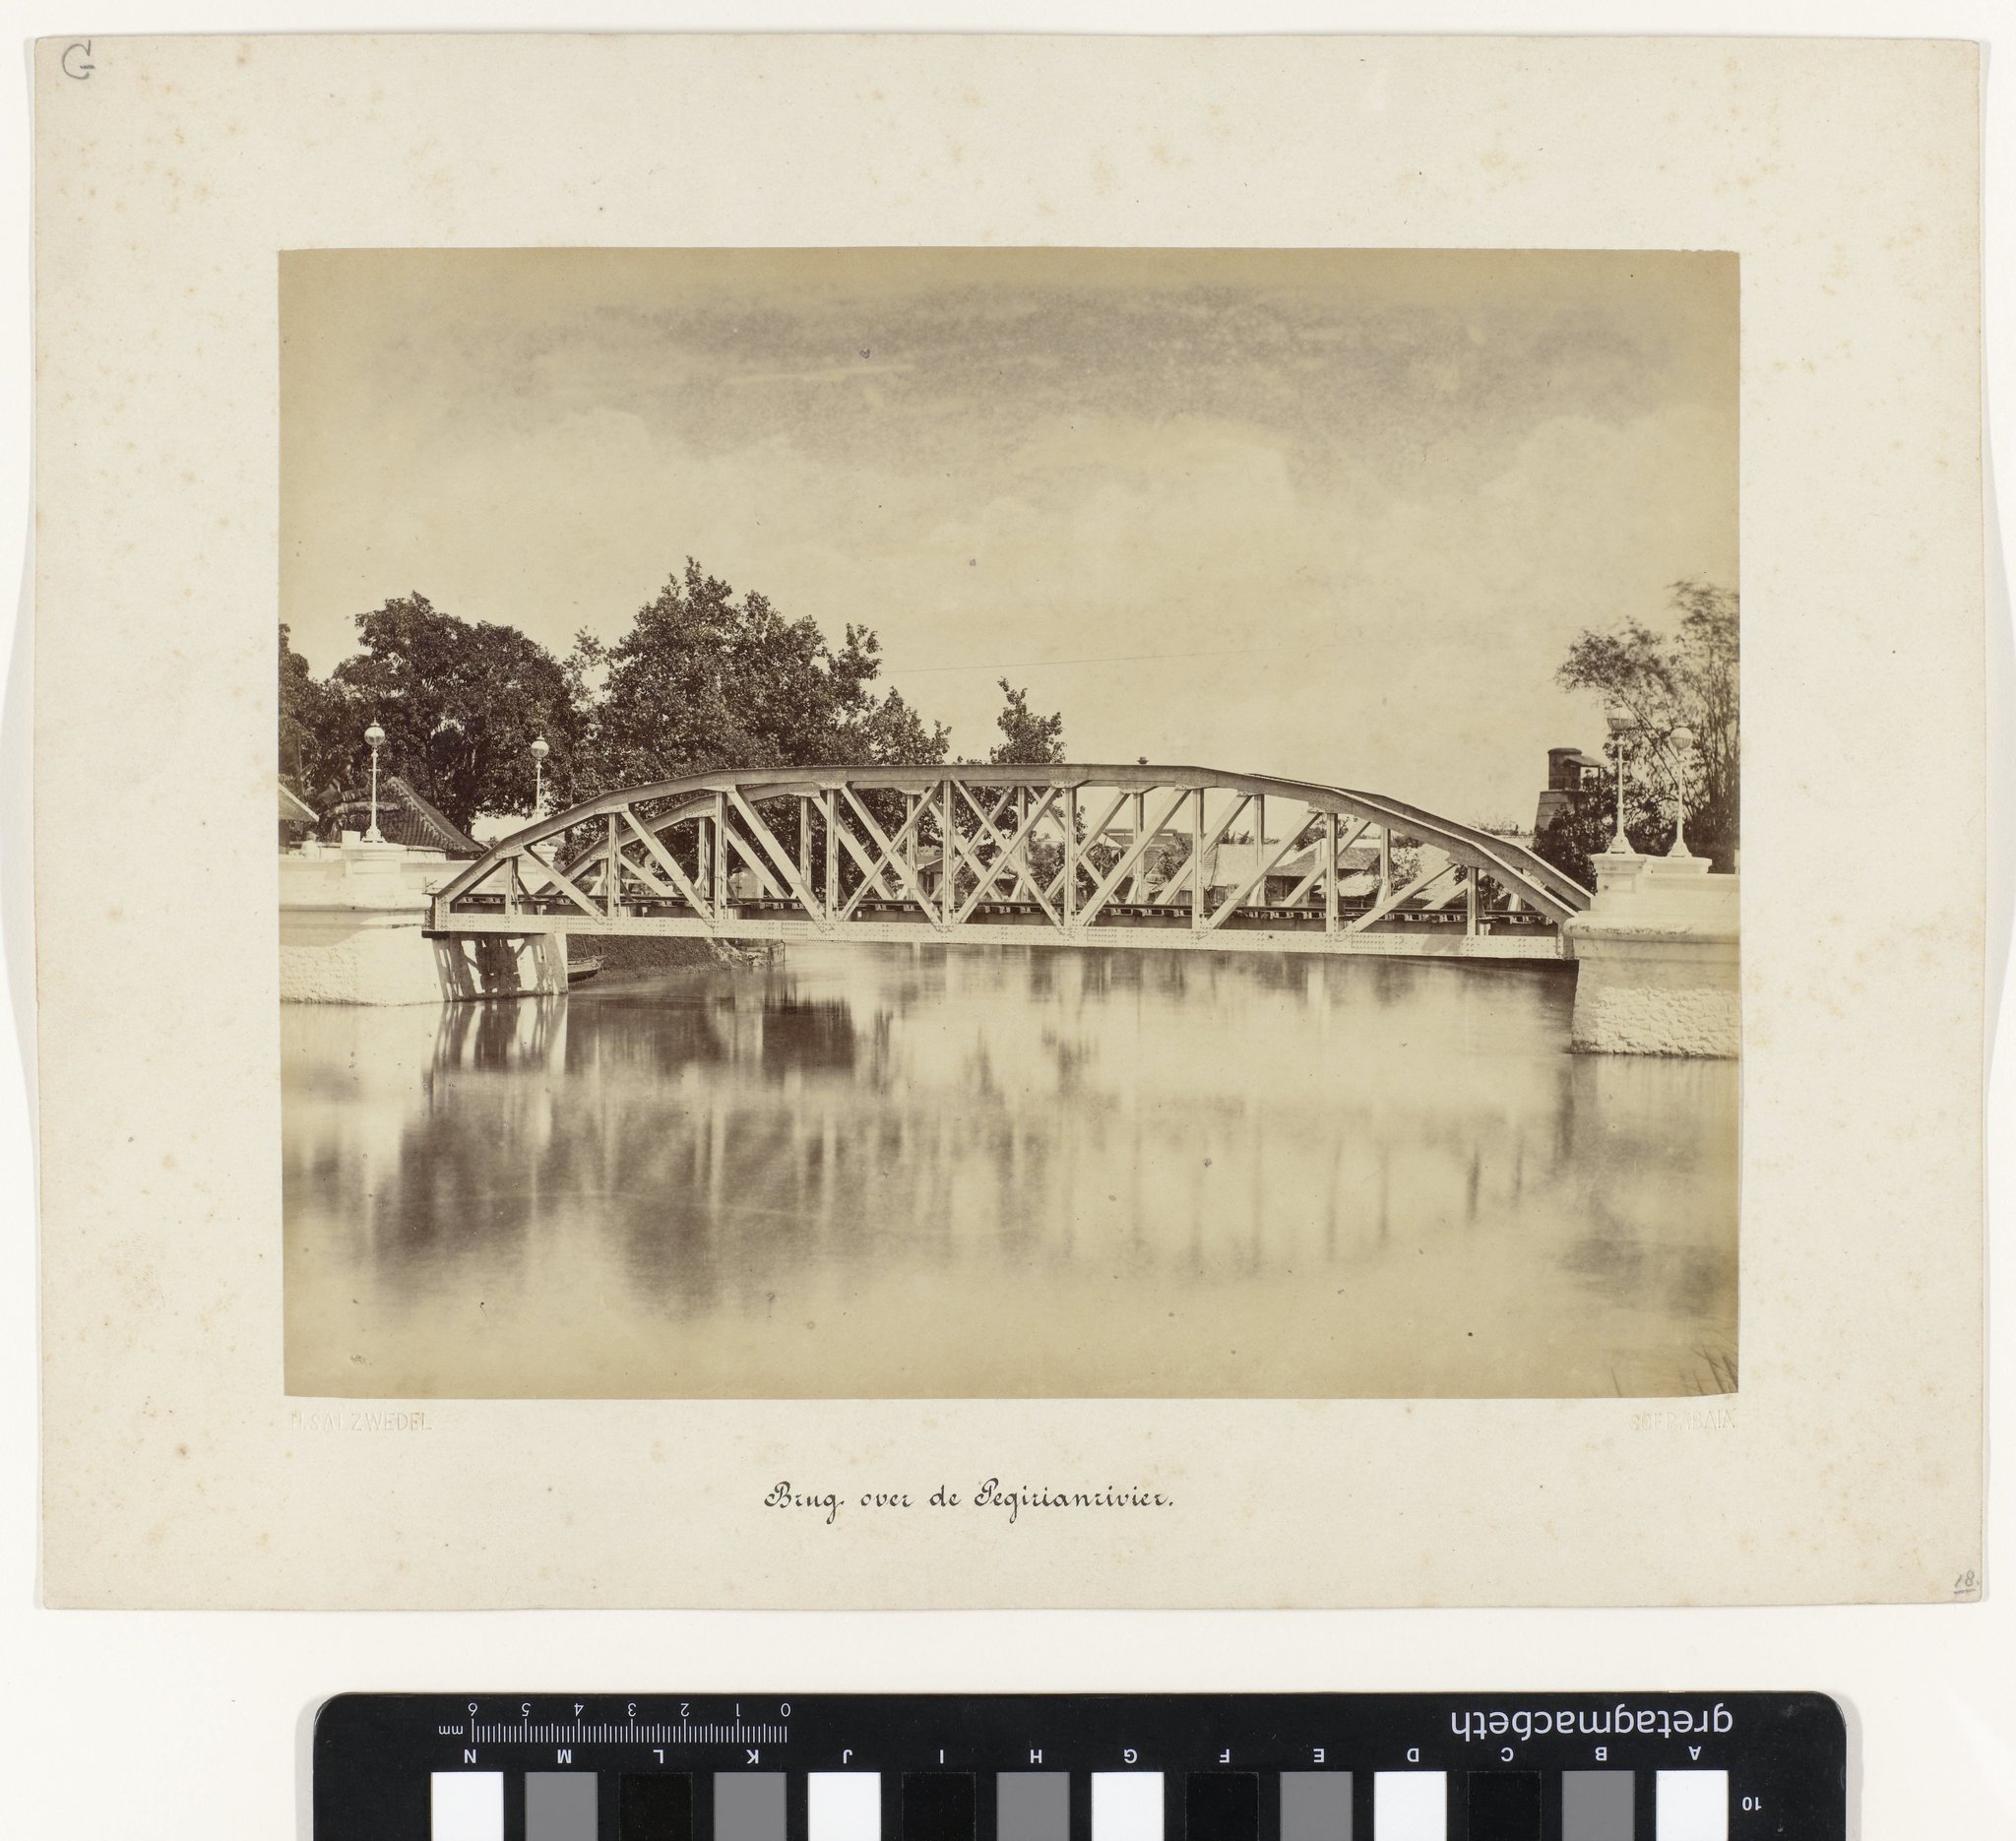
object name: photograph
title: Staatsspoorwegen op Java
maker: herman salzwedel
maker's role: fotograaf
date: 1880-1888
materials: photographic support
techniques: albumen print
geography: surabaya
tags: java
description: De spoorwegbrug over de Pegirian bij Soerebaja. Onderdeel van een groep van 62 foto's in een doos met het opschrift "Staatsspoorwegen op Java" uit 1888.